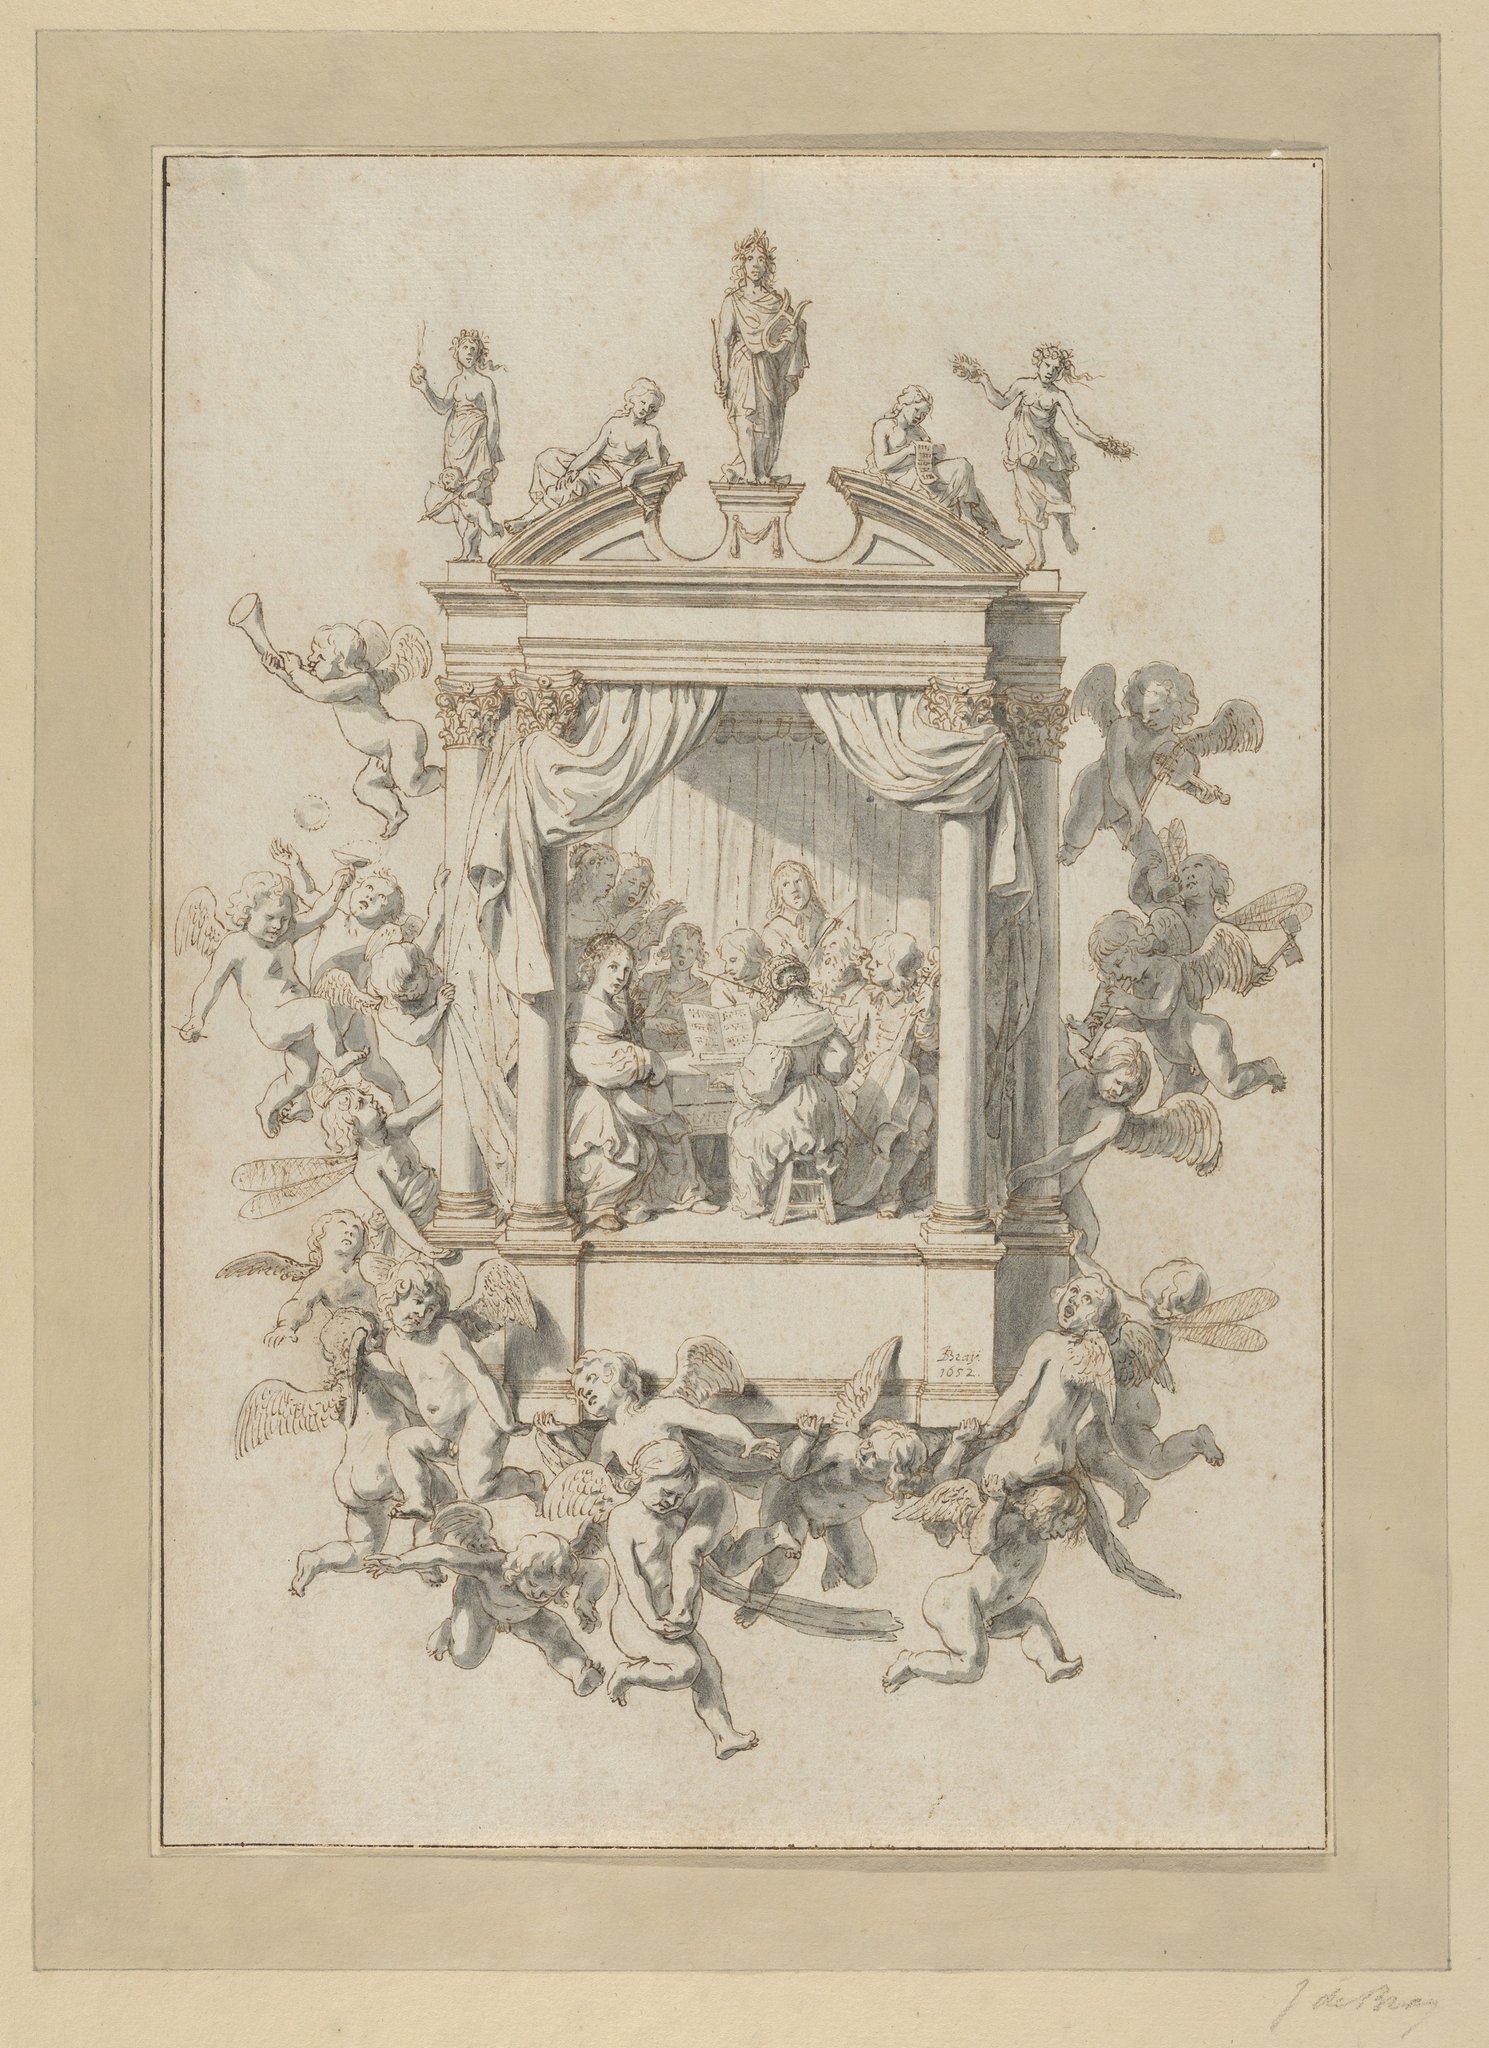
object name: drawing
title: A Group of Men and Women Playing Chamber Music Within a Portico, Surmounted by Statues of Apollo and Female Figures, and Surrounded by Putti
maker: jan de bray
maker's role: artist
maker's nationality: dutch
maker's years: 1622-1697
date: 1652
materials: chalk, ink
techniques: pen, wash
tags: musical instruments,men,women,apollo,putti,musicians